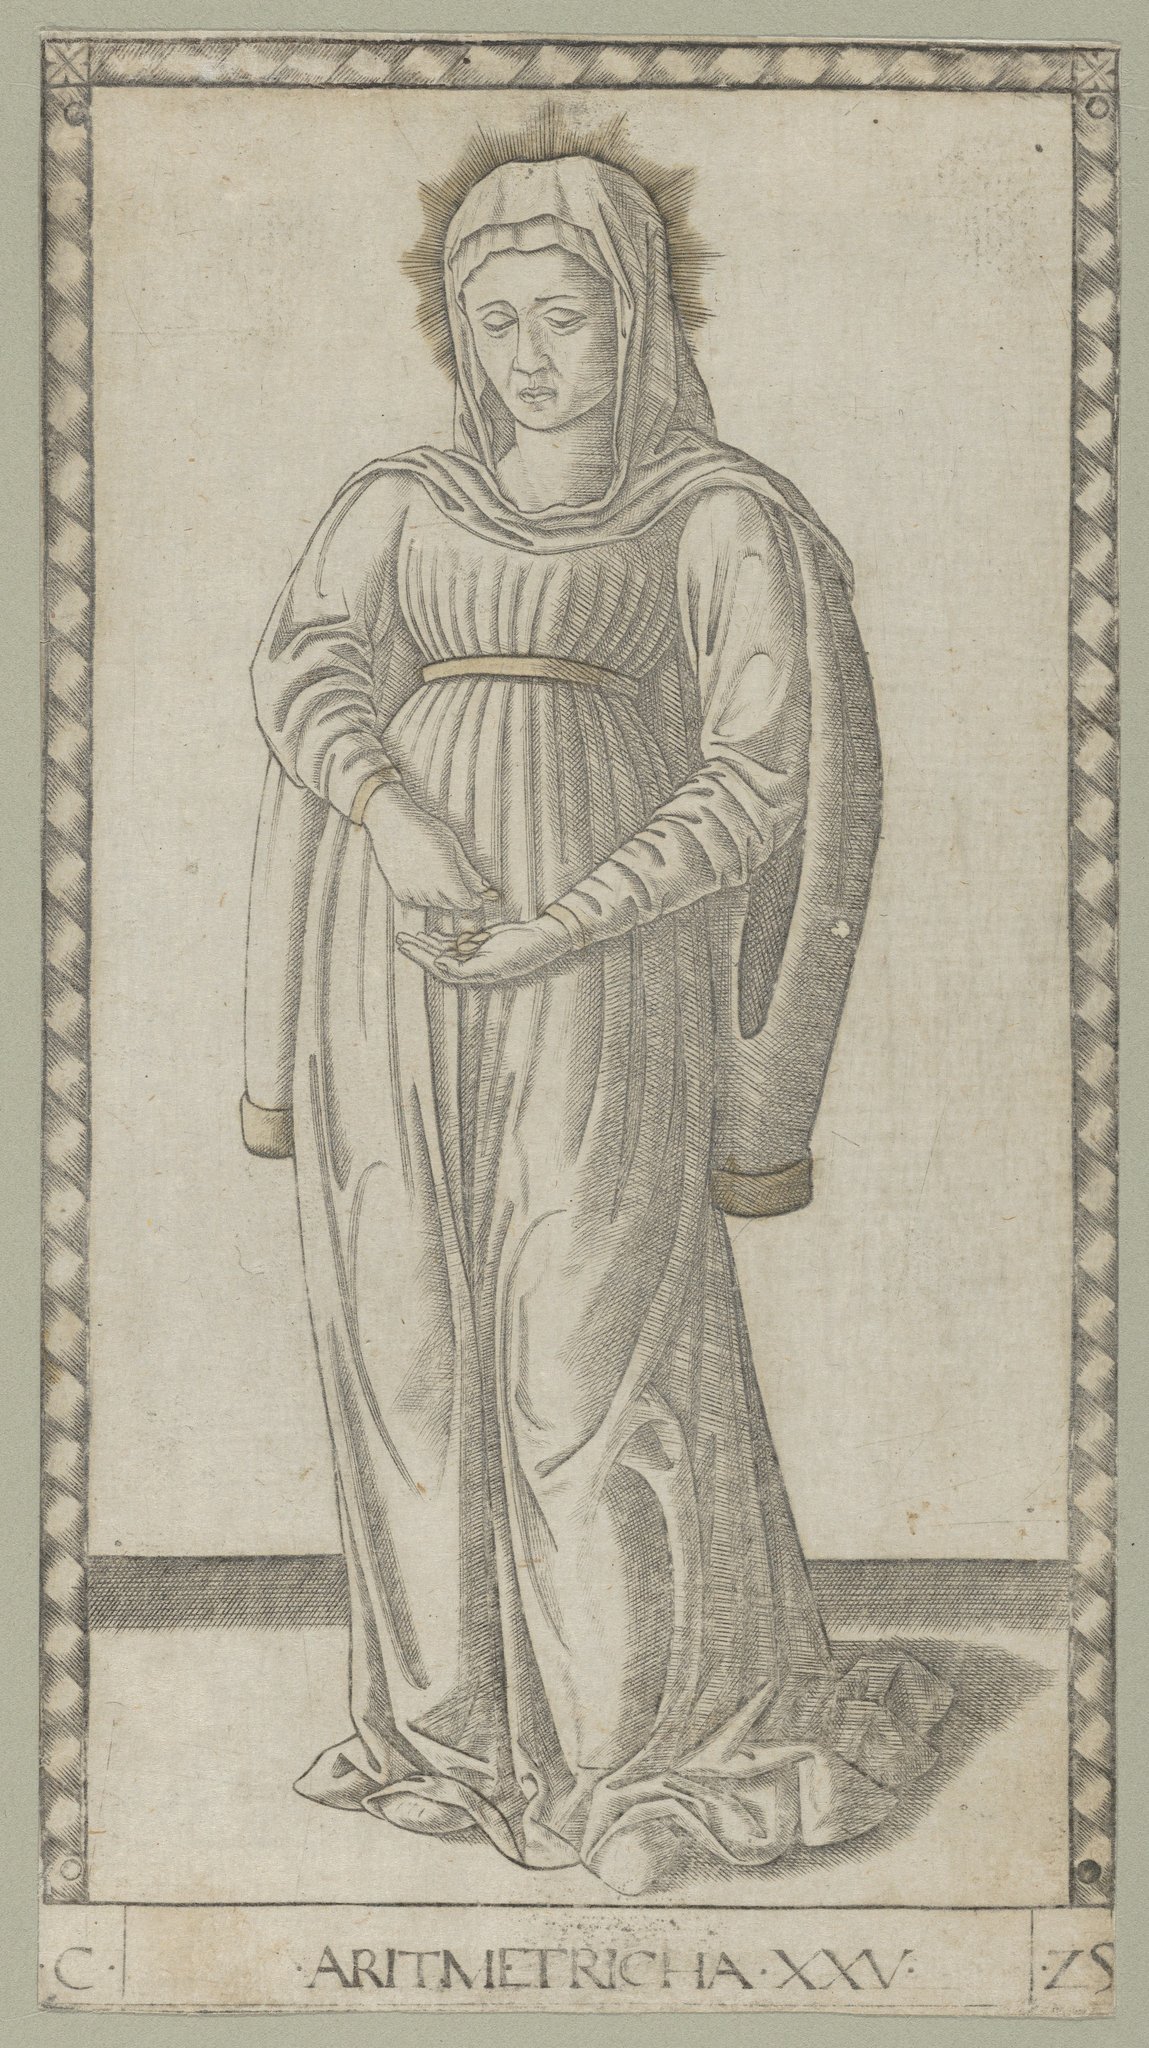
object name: print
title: Arithmetic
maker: master of the e-series tarocchi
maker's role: artist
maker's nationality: italian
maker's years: 1460-1475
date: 1460-1470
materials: gold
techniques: engraving, hand coloring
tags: women